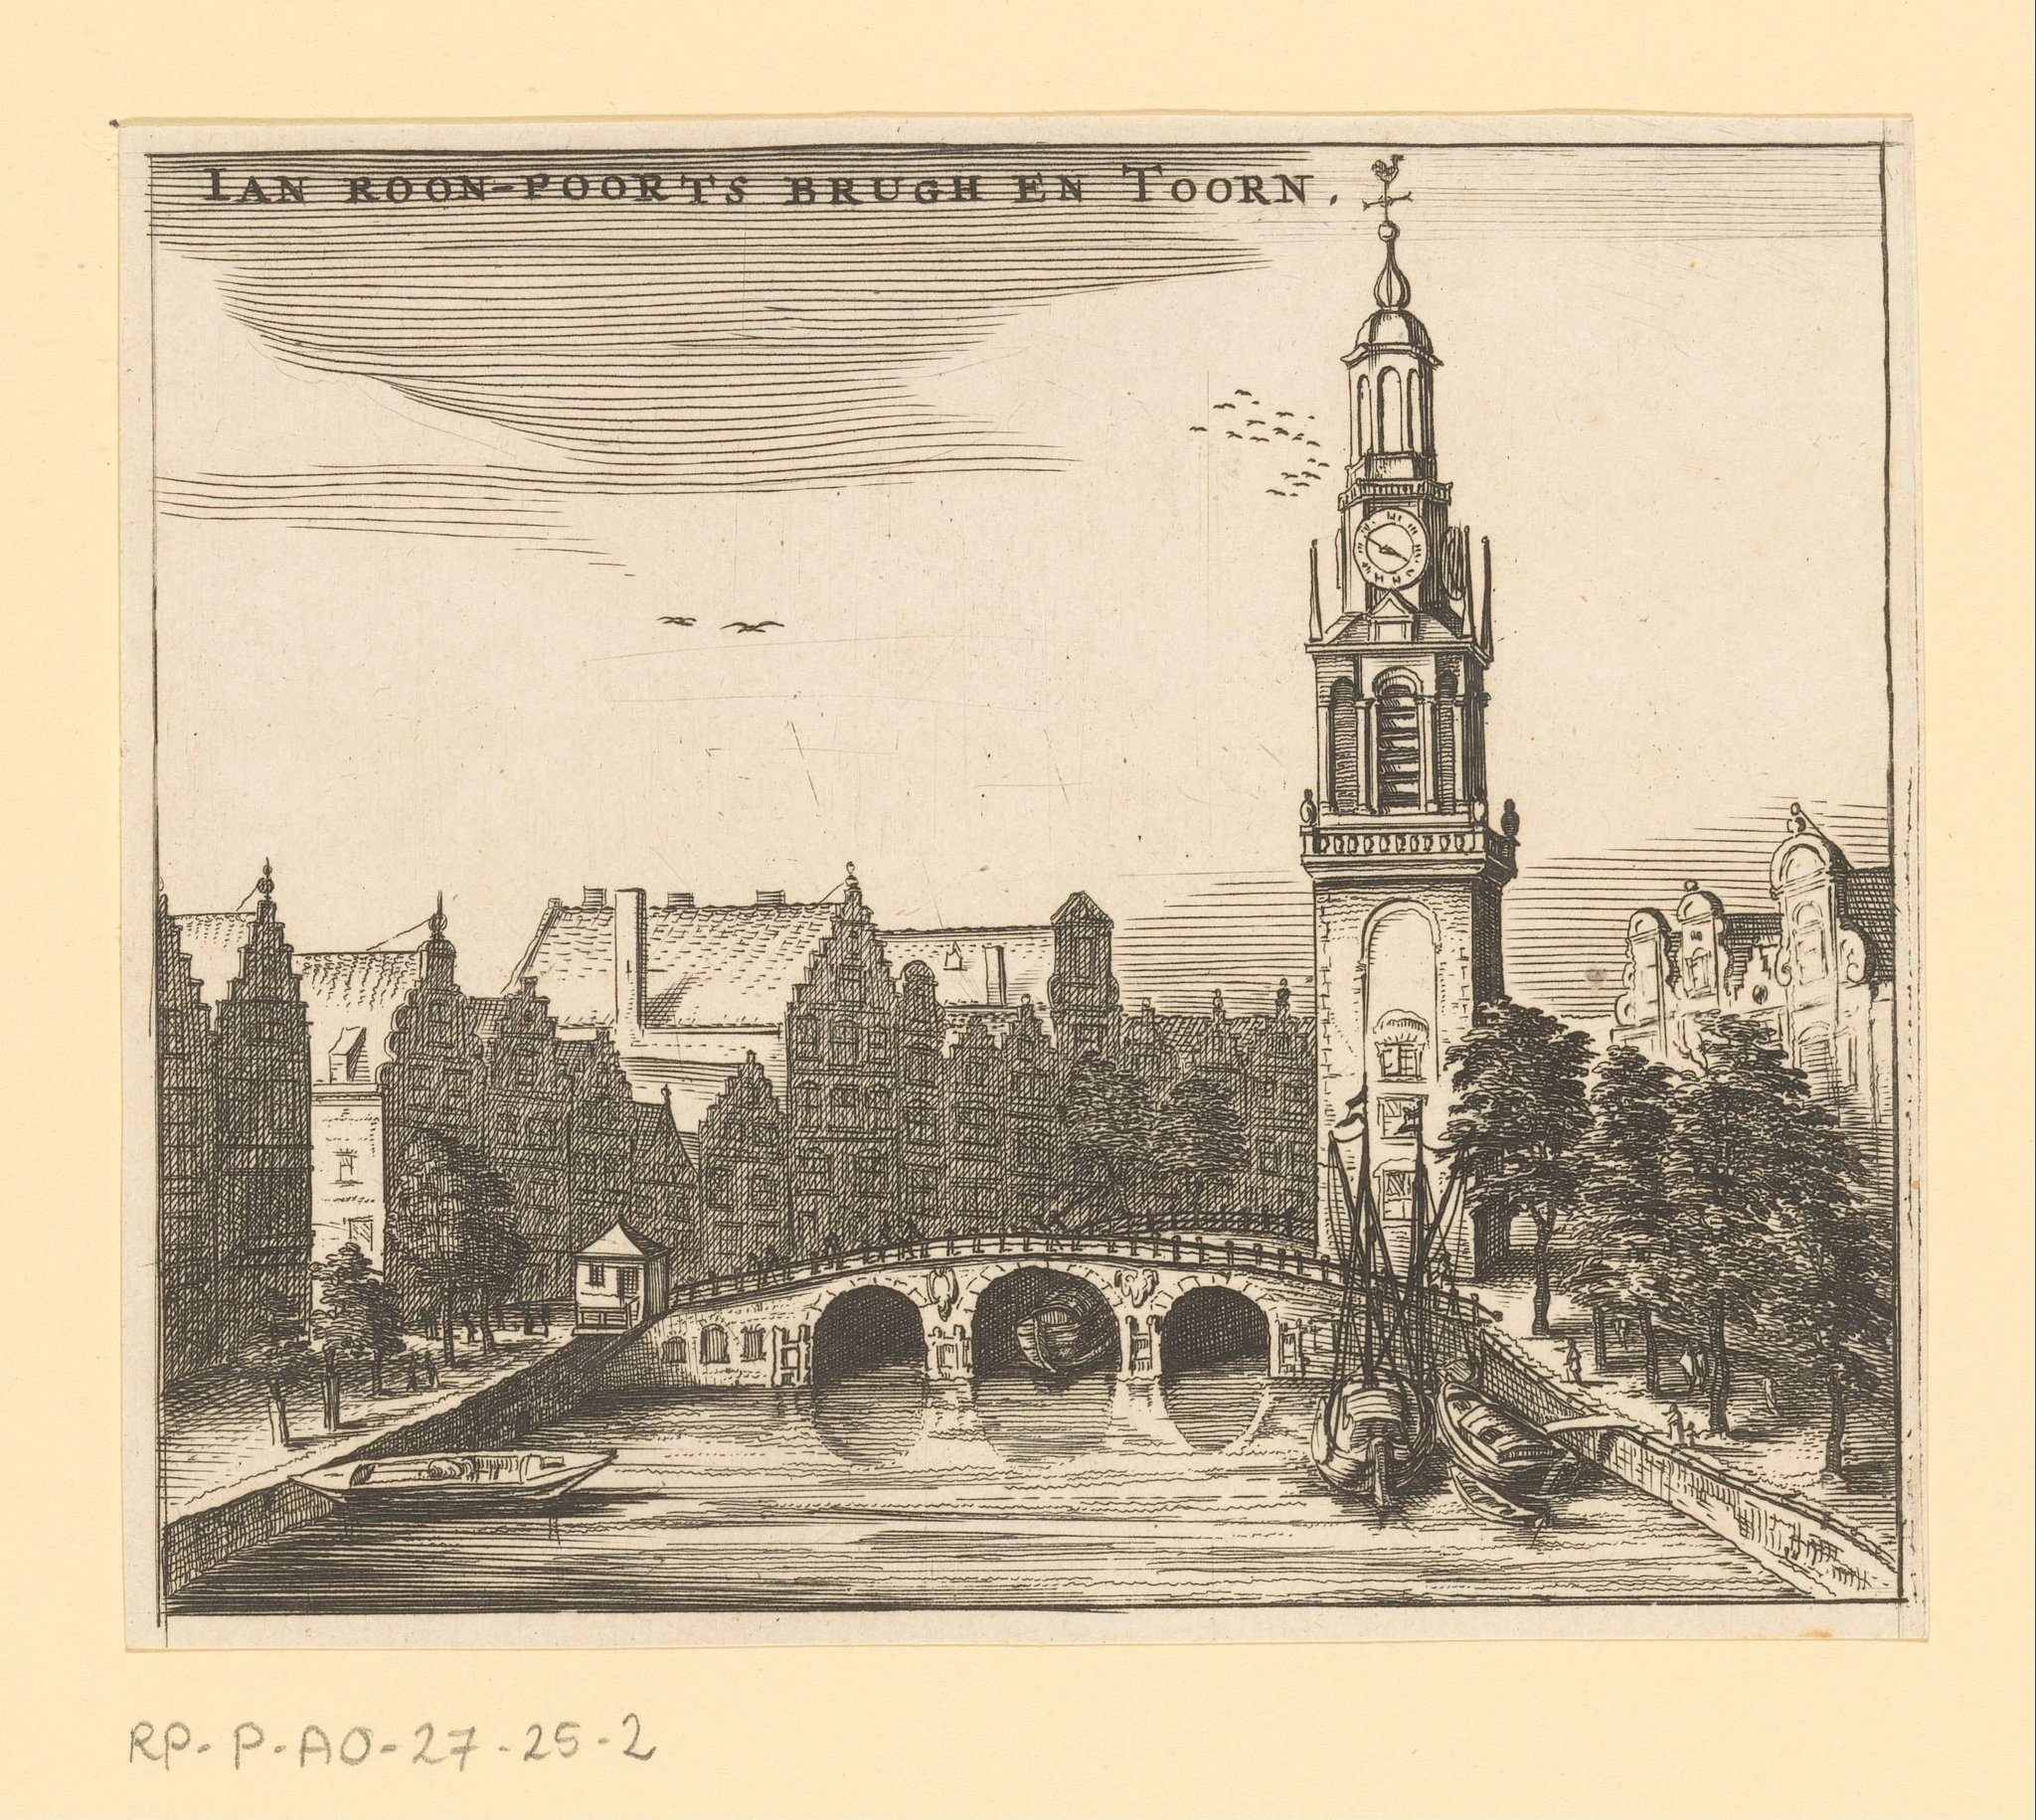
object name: print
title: Ian Roon-poorts brugh en Toorn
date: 1664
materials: paper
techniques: engraving, etching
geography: amsterdam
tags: bridge in city across river, canal, etc. (+ city(-scape) with figures, staffage), tower, clock tower ~ monumental adornment, canals, waters (in city) (+ city(-scape) with figures, staffage), street (+ city(-scape) with figures, staffage)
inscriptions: collector's mark: Lugt 195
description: Huidige staat van prent ook gebruikt in: Fockens, Melchior. Beschrijving Der wijdt-vermaarde Koop-stadt Amstelredam, Van haar eerste beginselen, zedert den Jare 1203. oude Voorrechten, verscheyde Vergrootingenoude Voor-rechten, en verscheyde Vergrootingen (…). 3e druk. Amsterdam: Marcus Willemsz. Doornick, 1664. En in: Zesen, Philipp von. Beschrybung der Weidtberuhmde Kauf-Stadt Amstelredam / Beschreibung der Stadt Amsterdam darinnen von derselben ersten ursprunge bis auf gegenwartigen zustand (…). Amsterdam: Marcus Willemsz. Doornick, 1664. Tweede bekende staat (met toevoeging Franse titel) ook gebruikt in: Domselaer, Tobias en Isaac Commelin. Beschryvinge van Amsterdam : haar eerste oorspronk uyt den huyze der heeren van Aemstel en Aemstellant (…). 6 delen. Amsterdam: Marcus Willemsz van Doornick, 1665. Derde bekende staat (rechtsboven genummerd: 59) ook gebruikt in verschillende latere zeventiende- en achttiende-eeuwse publicaties.